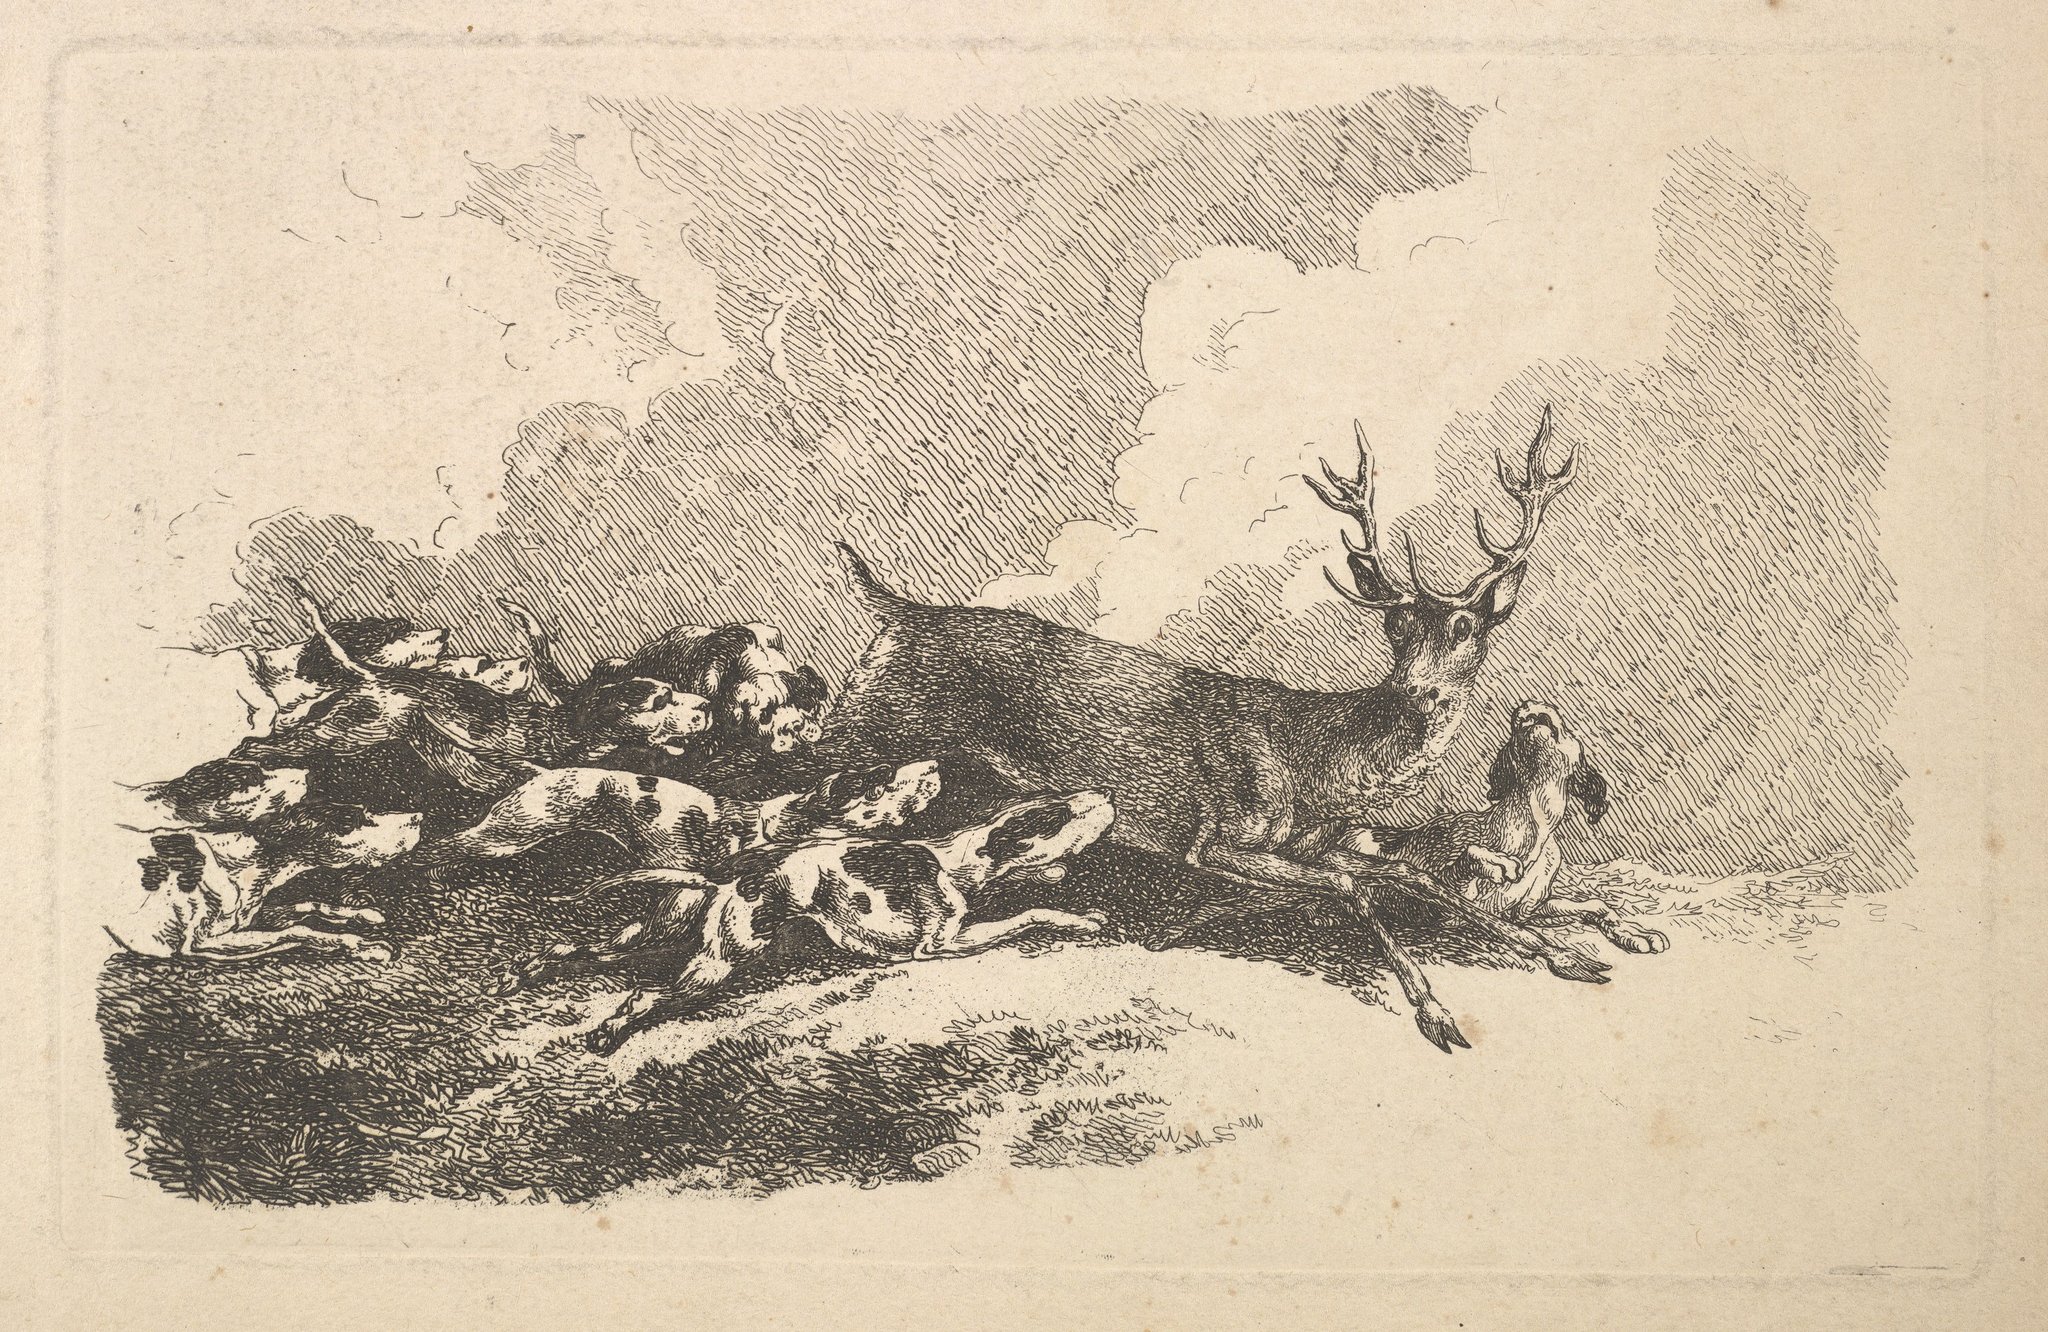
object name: print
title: Hounds Hunting a Stag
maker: thomas rowlandson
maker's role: artist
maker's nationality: british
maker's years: 1757-1827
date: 1784-1788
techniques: etching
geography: england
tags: hunting,deer,dogs